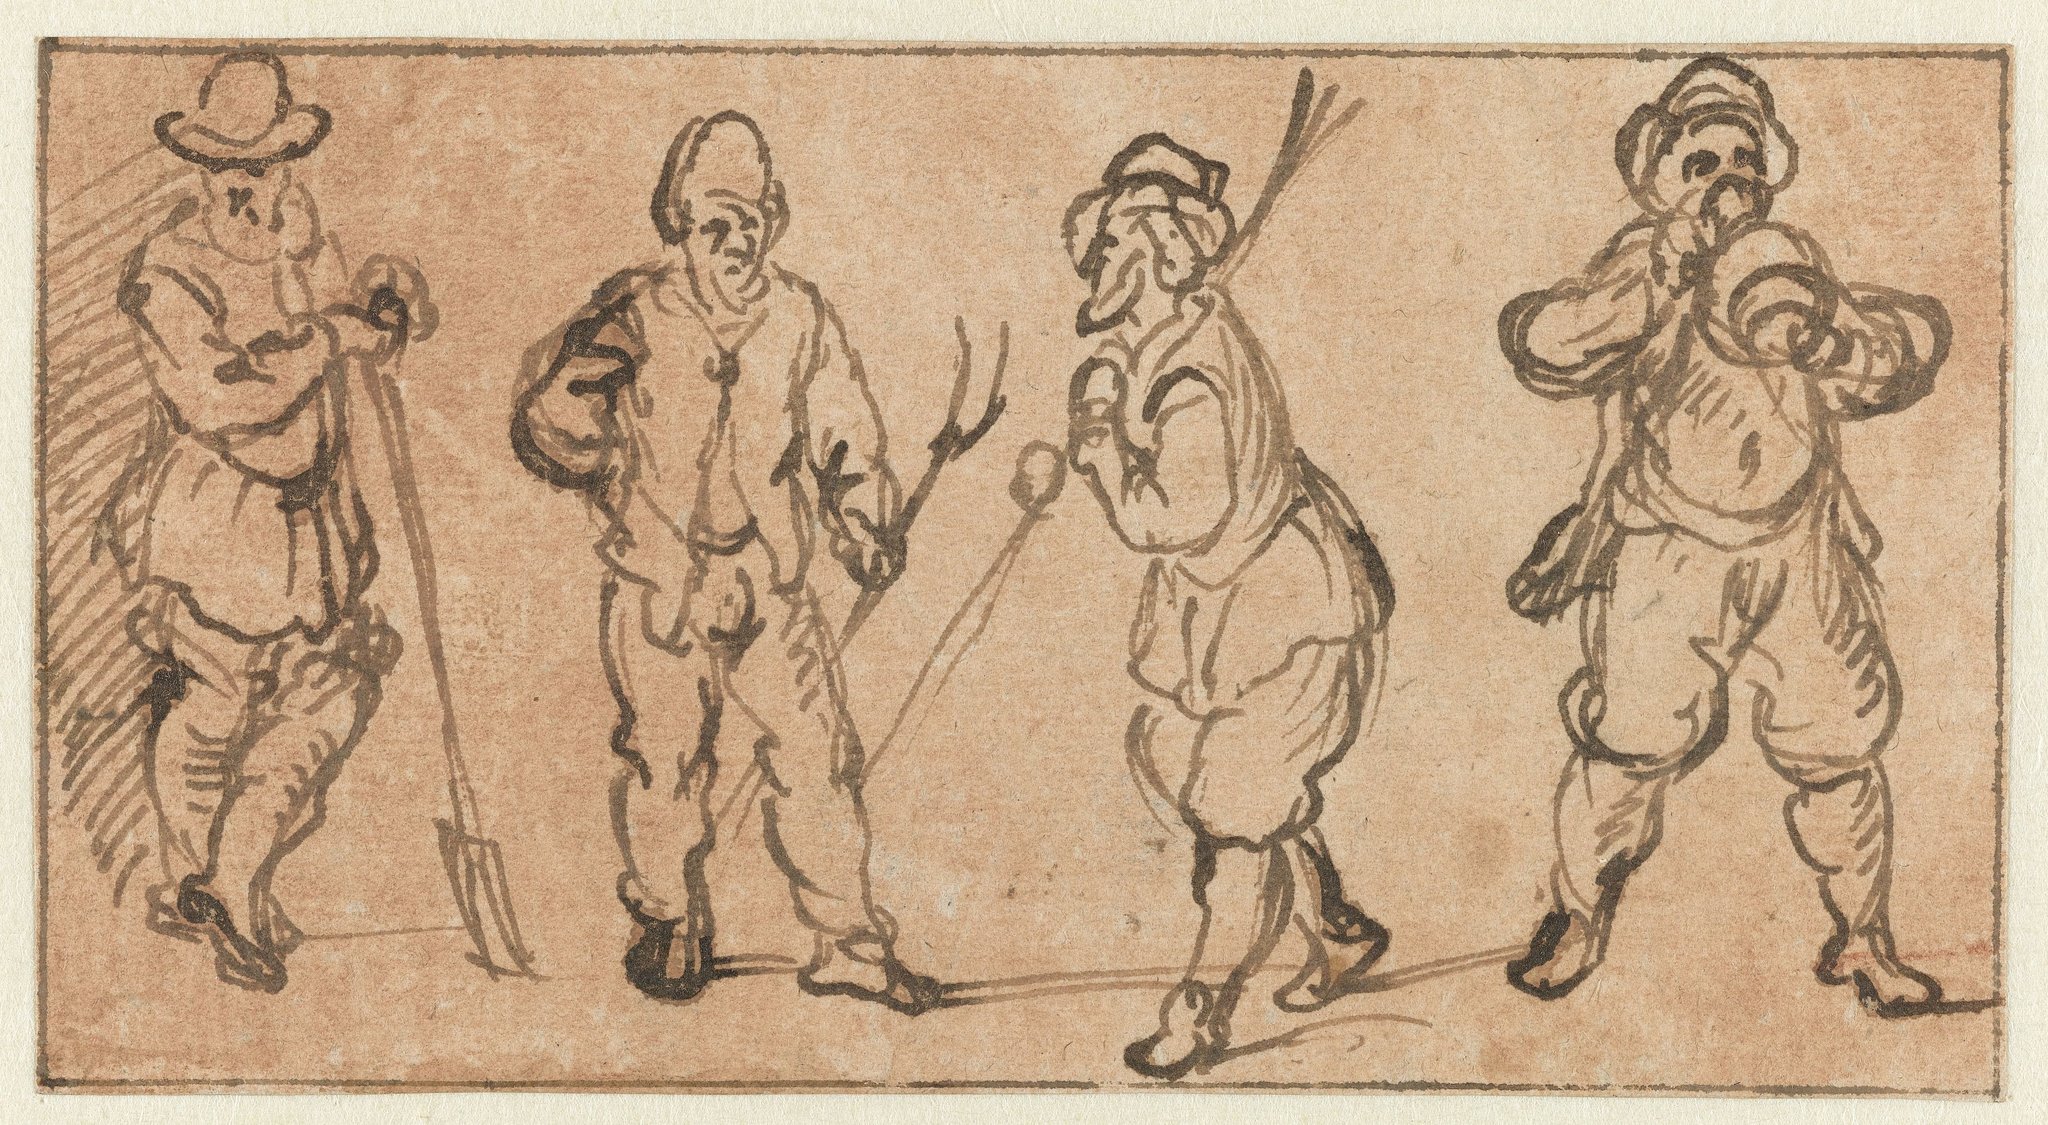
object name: drawing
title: Vier boeren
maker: jan van goyen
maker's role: draughtsman, painter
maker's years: 1596-1656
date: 1606-1656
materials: ink, paper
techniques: pen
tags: standing figure, farmers, leaning figure